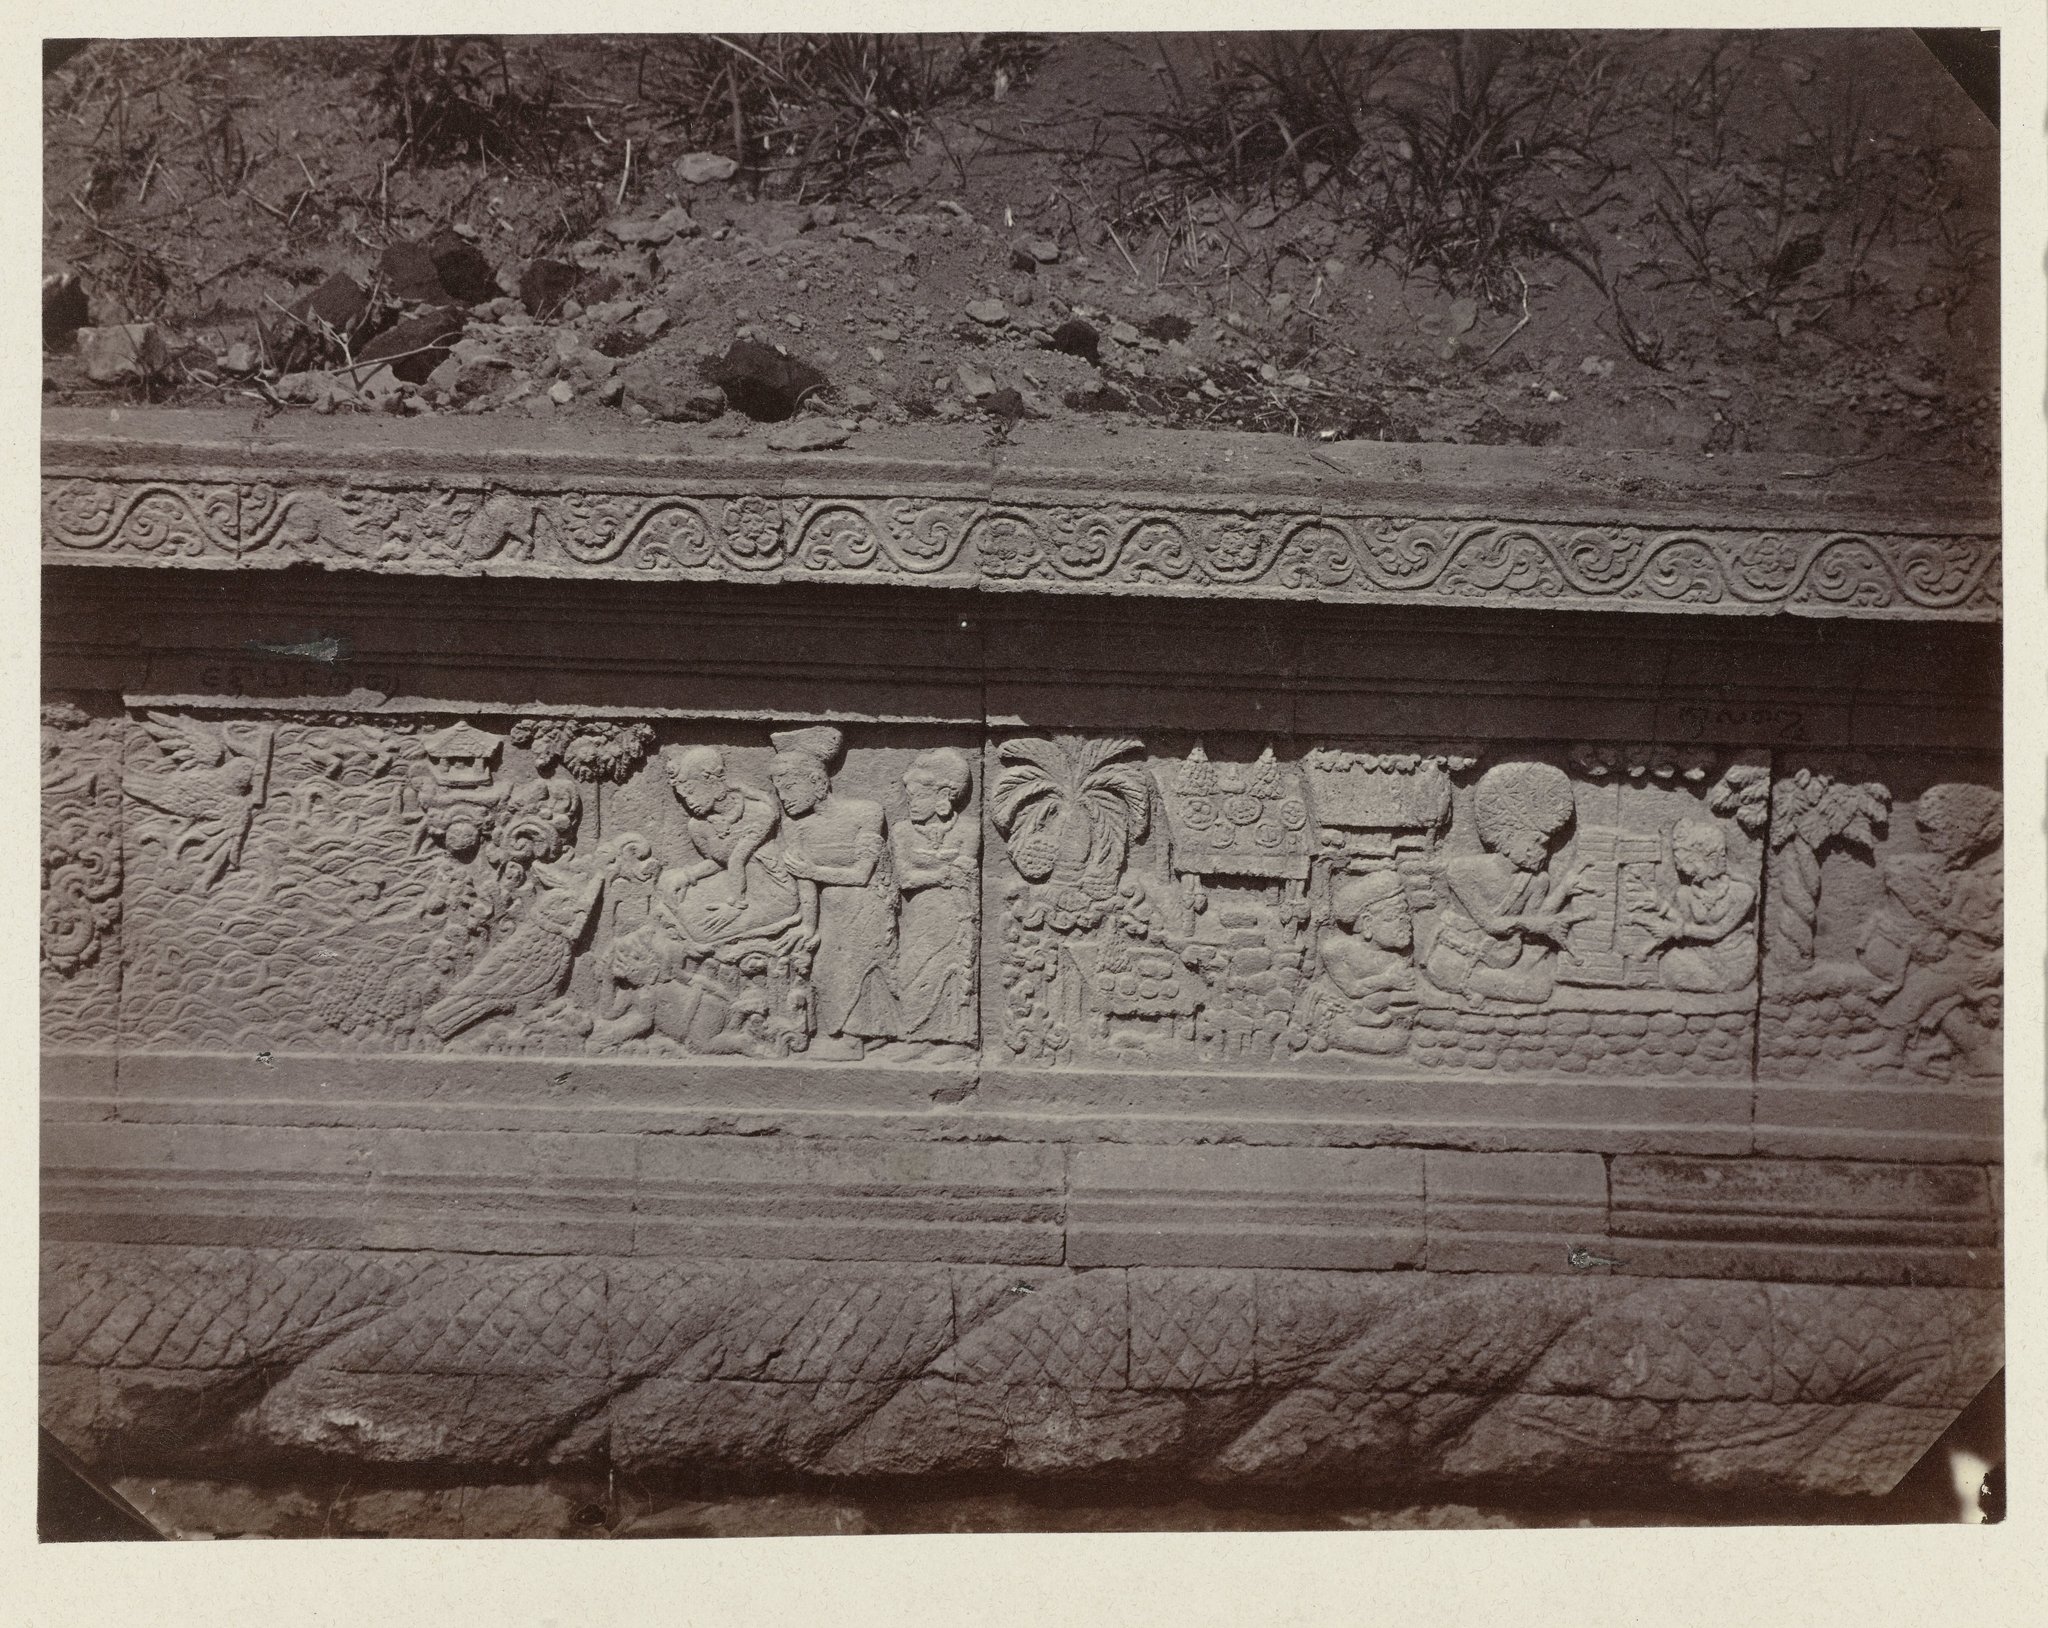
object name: photograph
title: Basreliëf op het pendopo voetstuk aan de westzijde van Candi Panataran.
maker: isidore kinsbergen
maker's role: fotograaf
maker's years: 1821-1905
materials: cardboard, paper, photographic support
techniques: albumen print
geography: java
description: Candi Panataran (Temple Complex), Pendopo Terrace, unidentified reliefs 50-52 ('Parrot' story), west side. Panataran, Blitar district, East Java province, 1375 AD